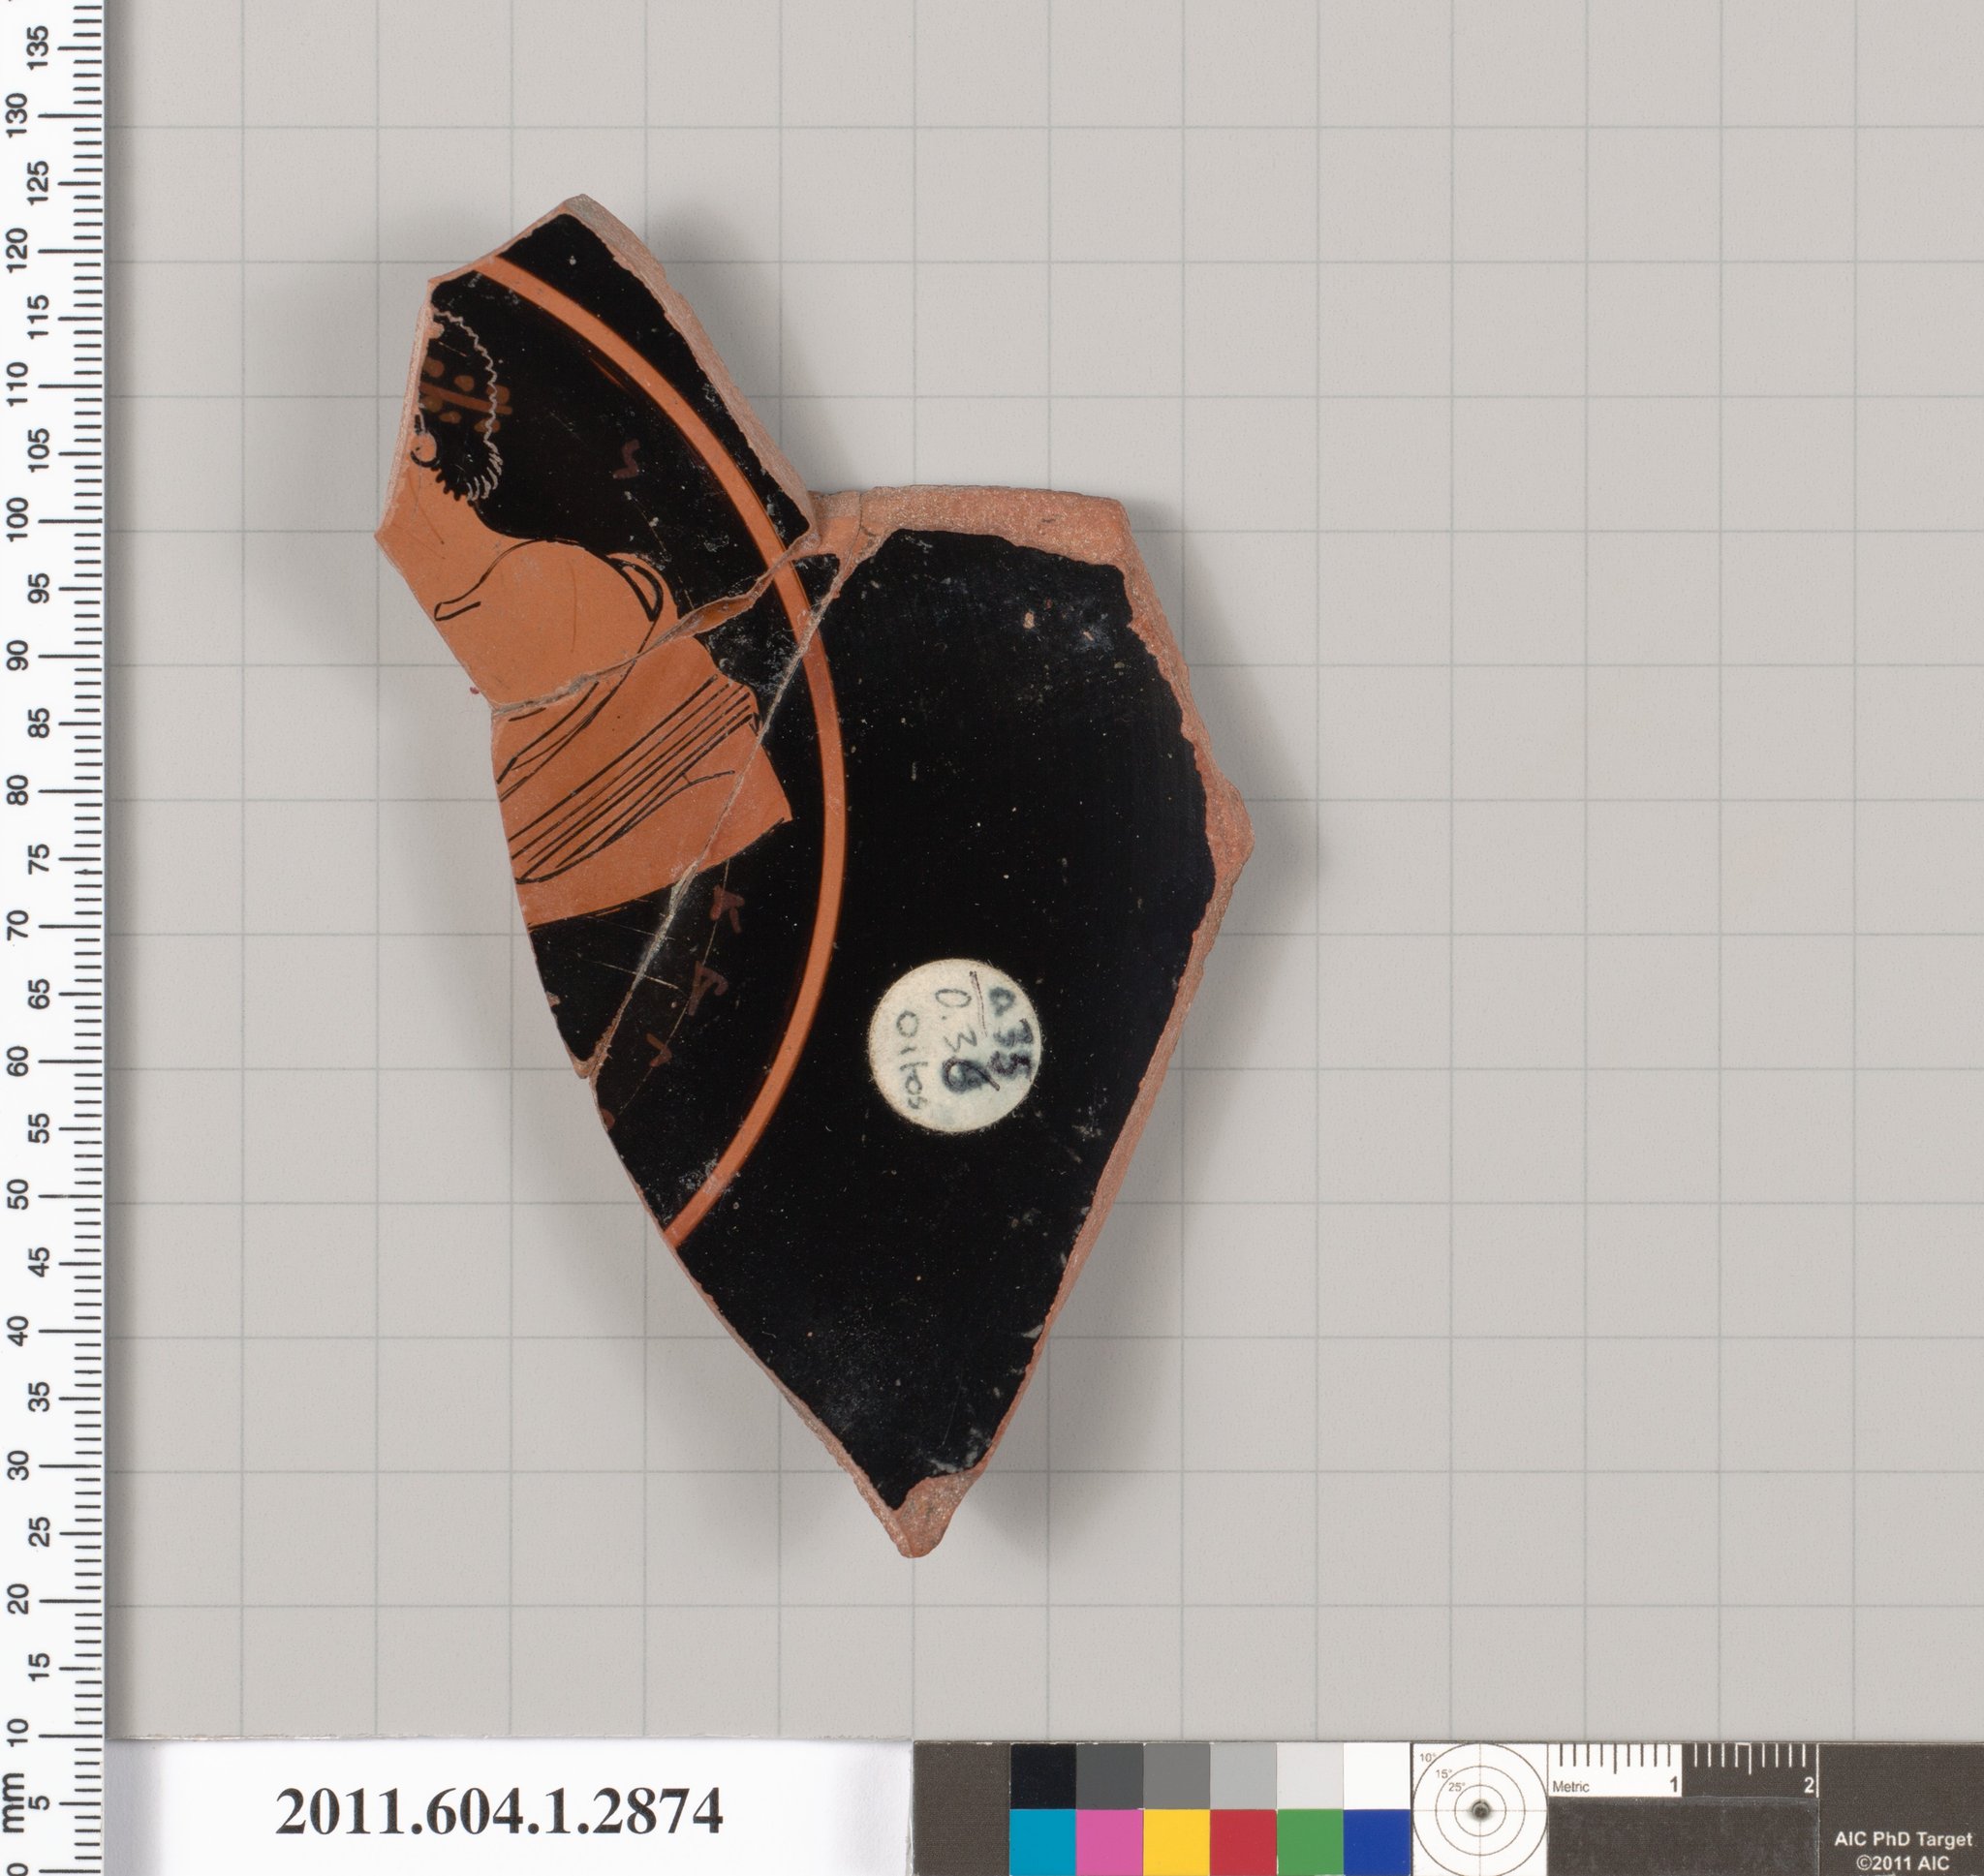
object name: kylix fragment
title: Terracotta fragment of a kylix (drinking cup)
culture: greek, attic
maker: oltos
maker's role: artist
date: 510-490 BCE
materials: terracotta